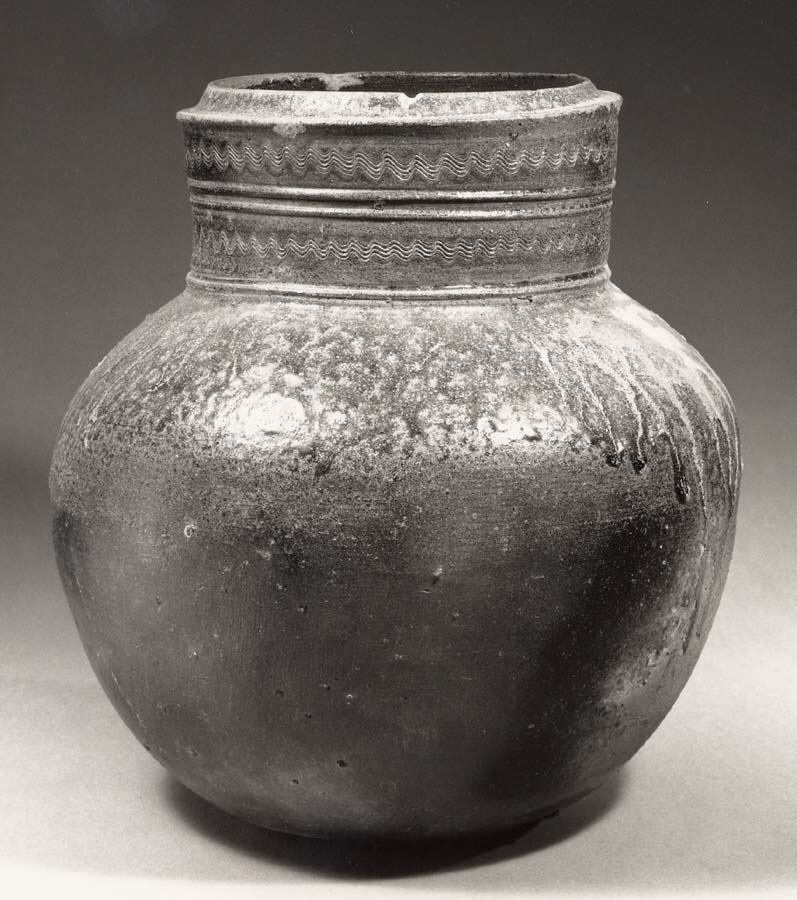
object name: jar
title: Globular Jar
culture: korean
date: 401-600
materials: pottery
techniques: firing